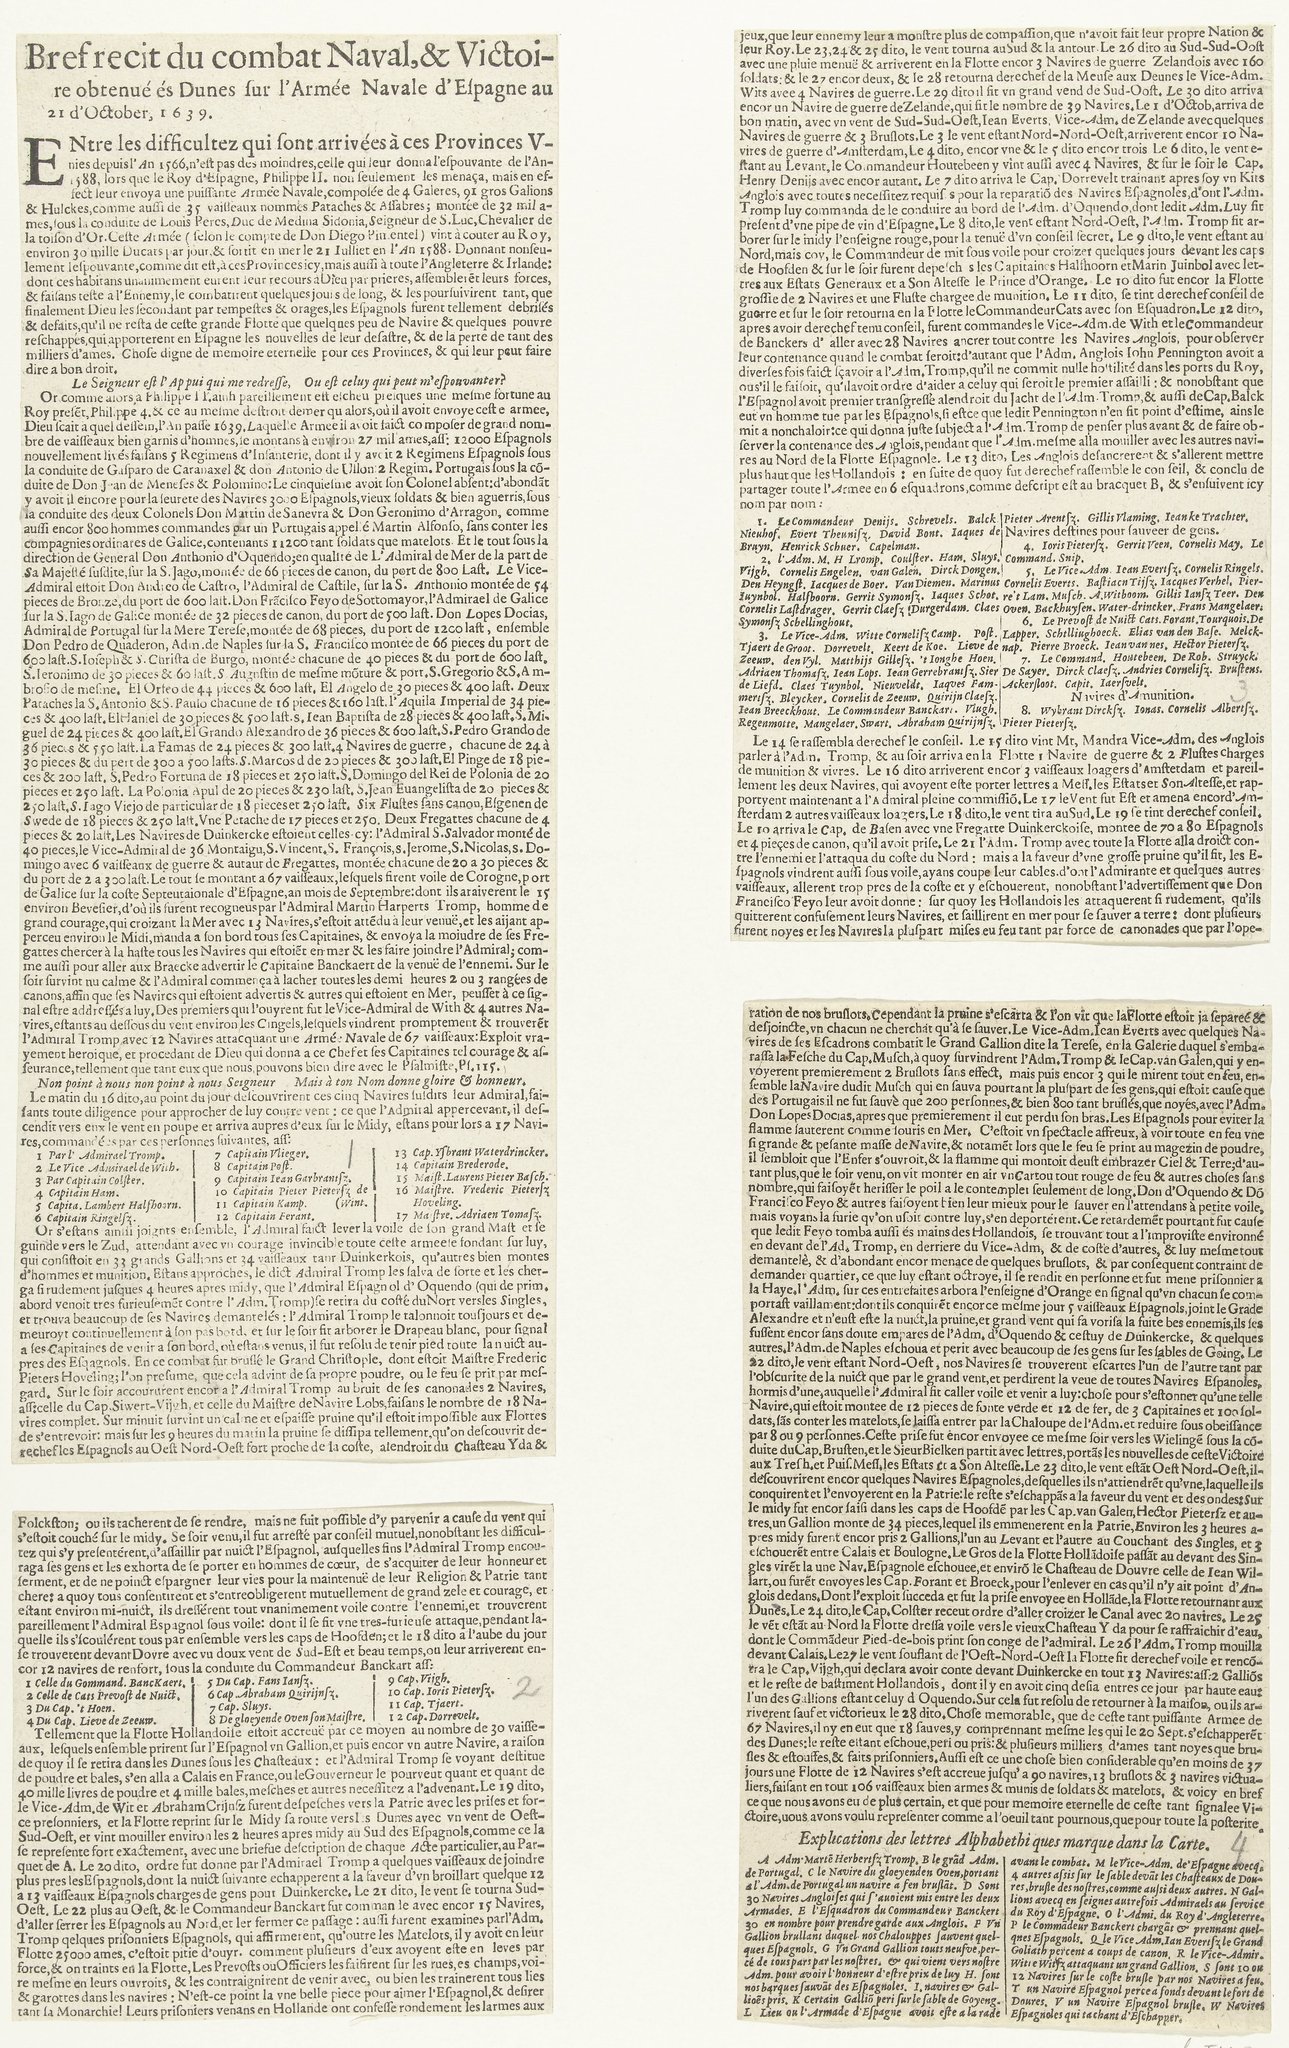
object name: print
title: Tekstblad bij een prent van de zeeslag bij Duins, 1639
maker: Anonymous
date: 1639-1640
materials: paper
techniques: letterpress printing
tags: brielle, maarten harpertszoon tromp, battle of the downs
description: Tekstblad bij de prent van de zeeslag bij Duins tussen de Spaanse vloot onder bevel van Antonio de Oquendo en de Staatse vloot onder Maarten Harpertsz. Tromp, 21 oktober 1639. Twee kolommen in 4 delen in het Frans, eindigend met de legenda A-W.